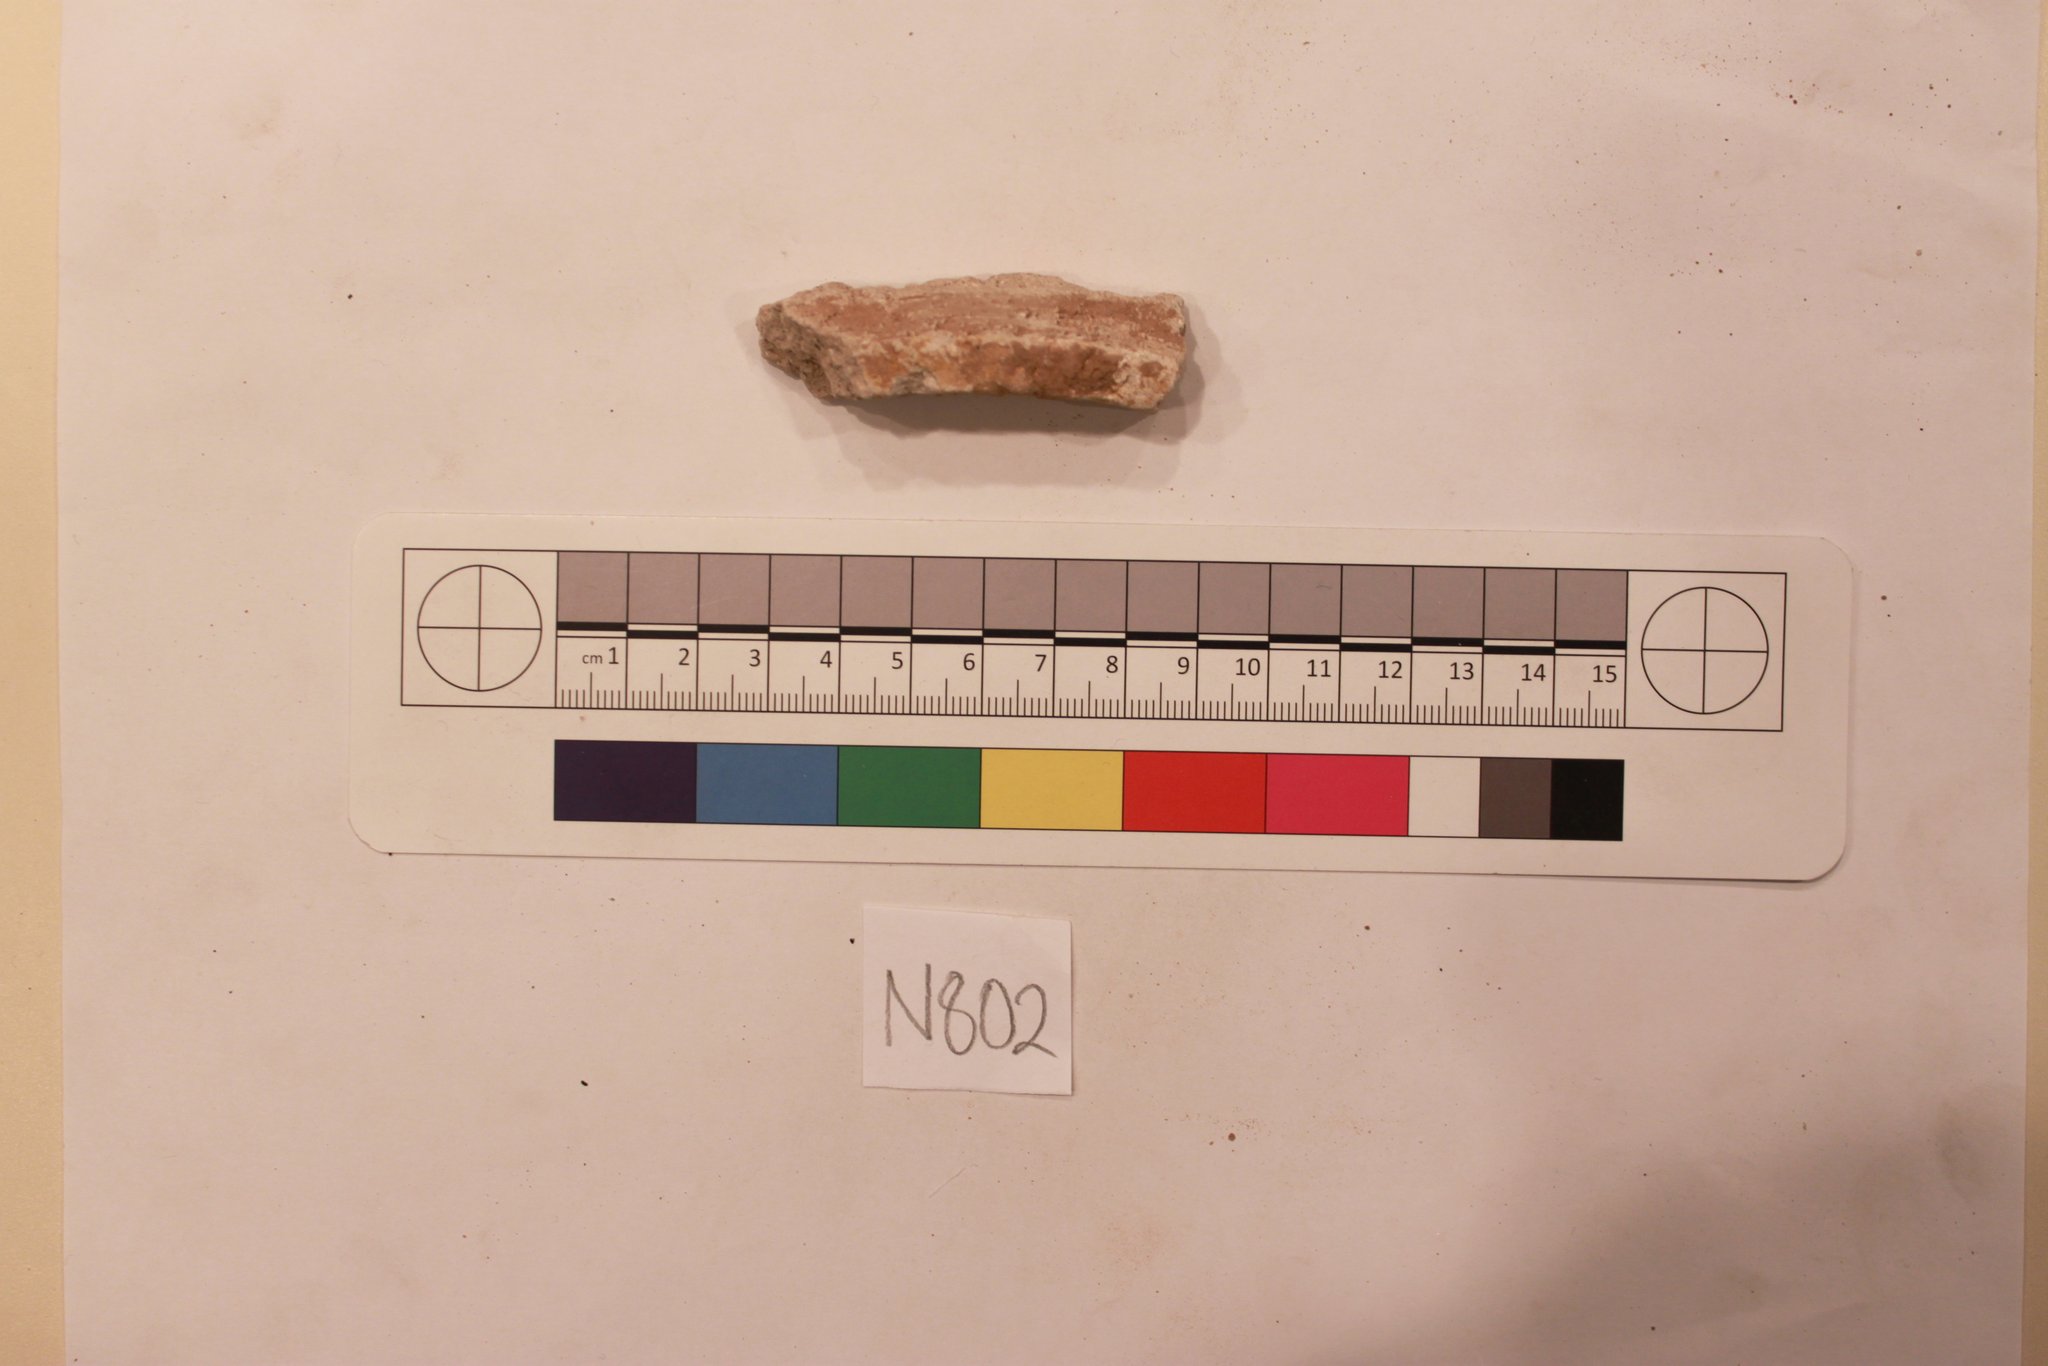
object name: fragment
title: Stucco Fragment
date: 701-1200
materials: plaster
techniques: carving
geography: iran